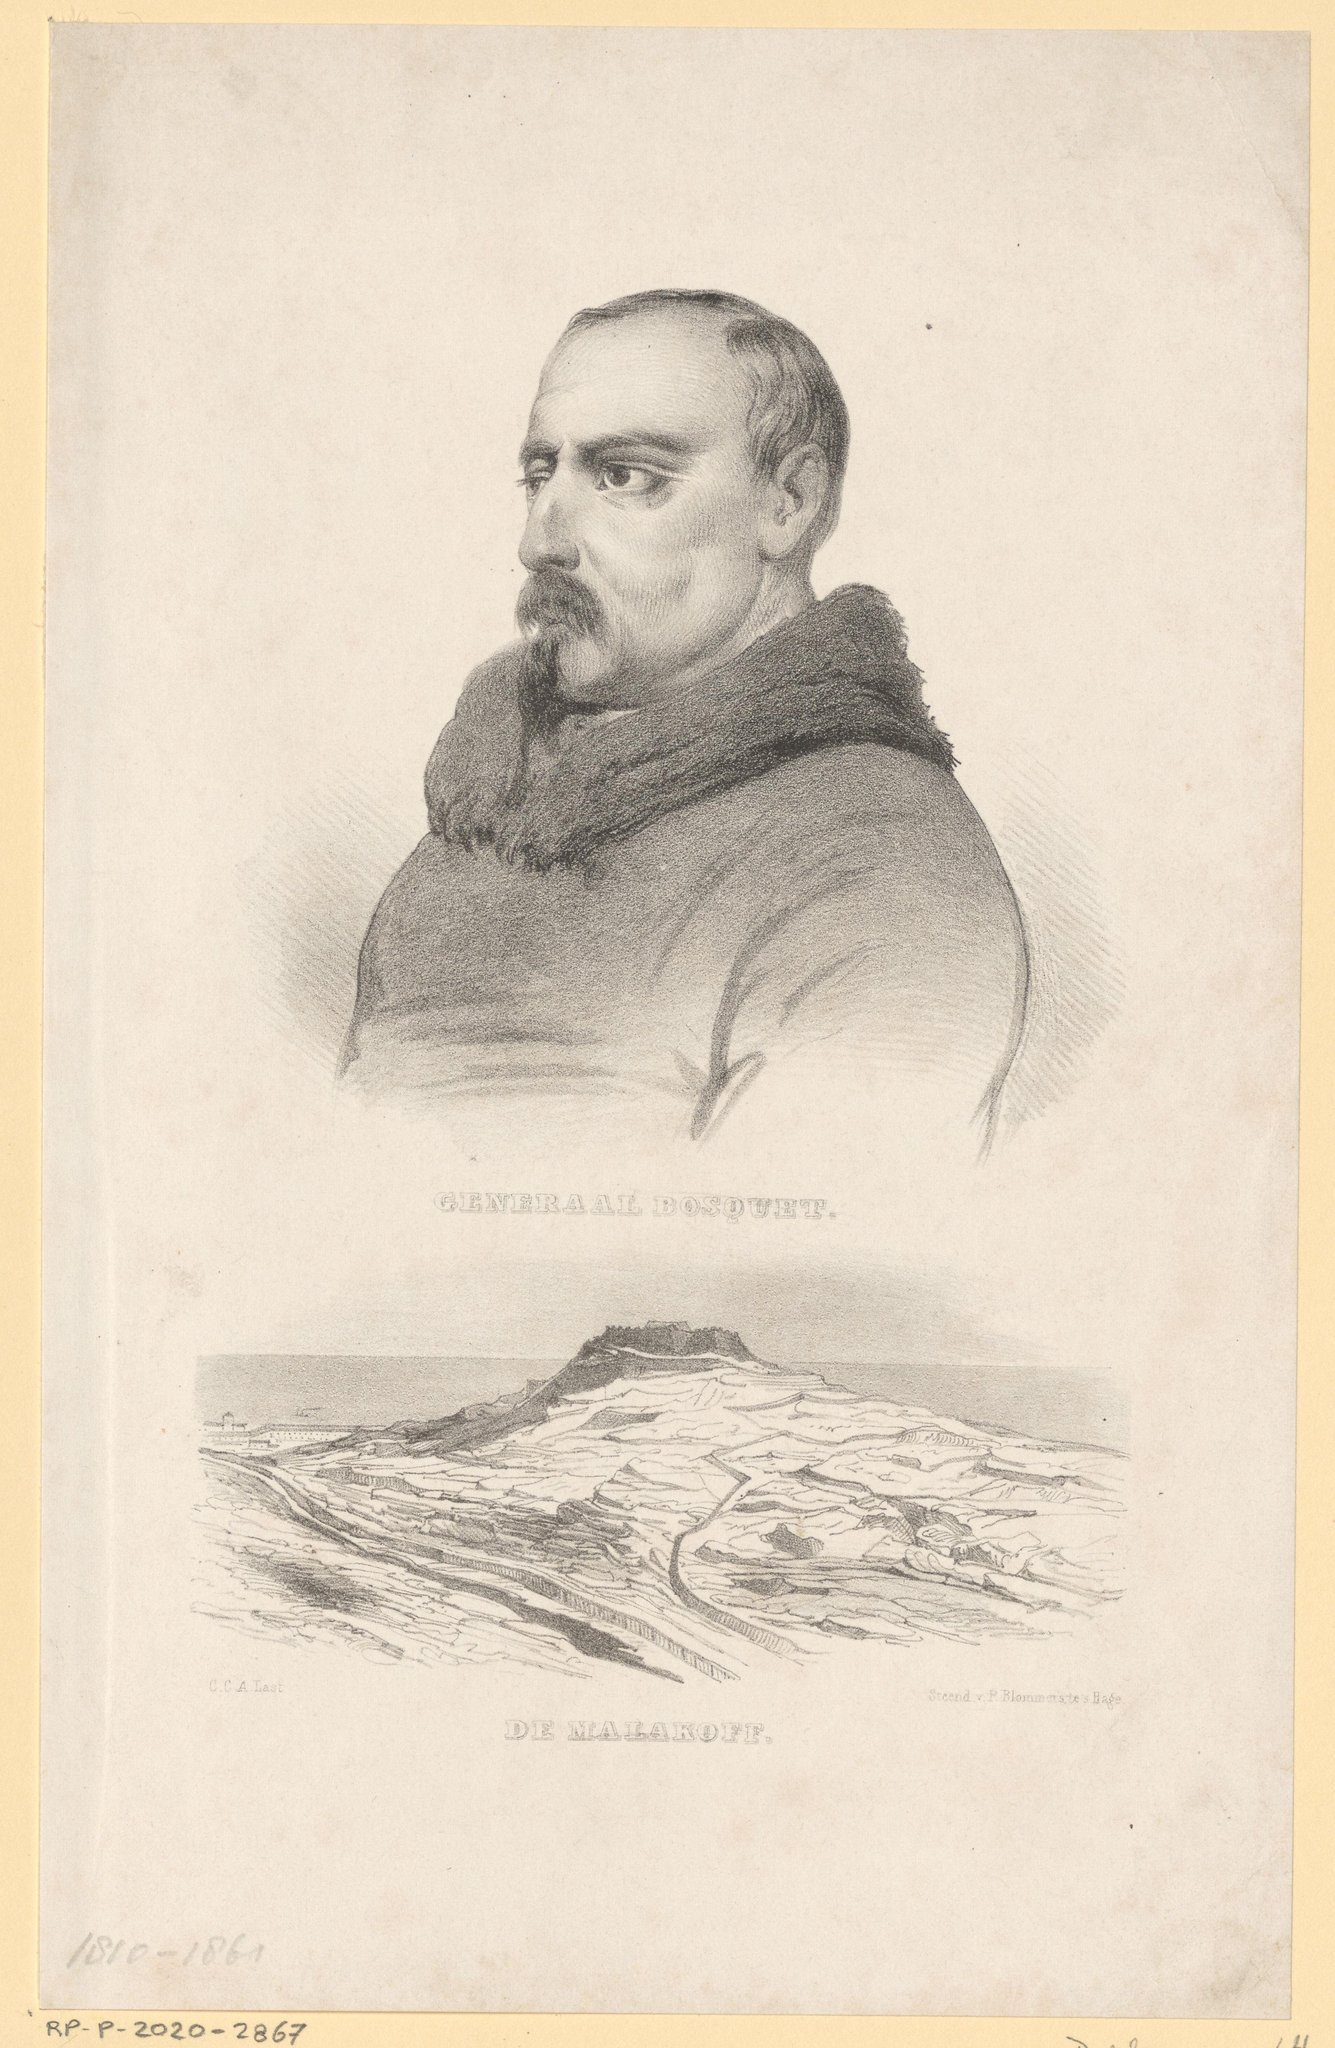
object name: print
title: Portret van Pierre-François-Joseph Bosquet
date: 1855-1876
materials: paper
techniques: lithograph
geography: the hague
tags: fortress, commander-in-chief, general, marshal, historical persons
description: Met midden onder een vignet met een gezicht op Fort Malachov.